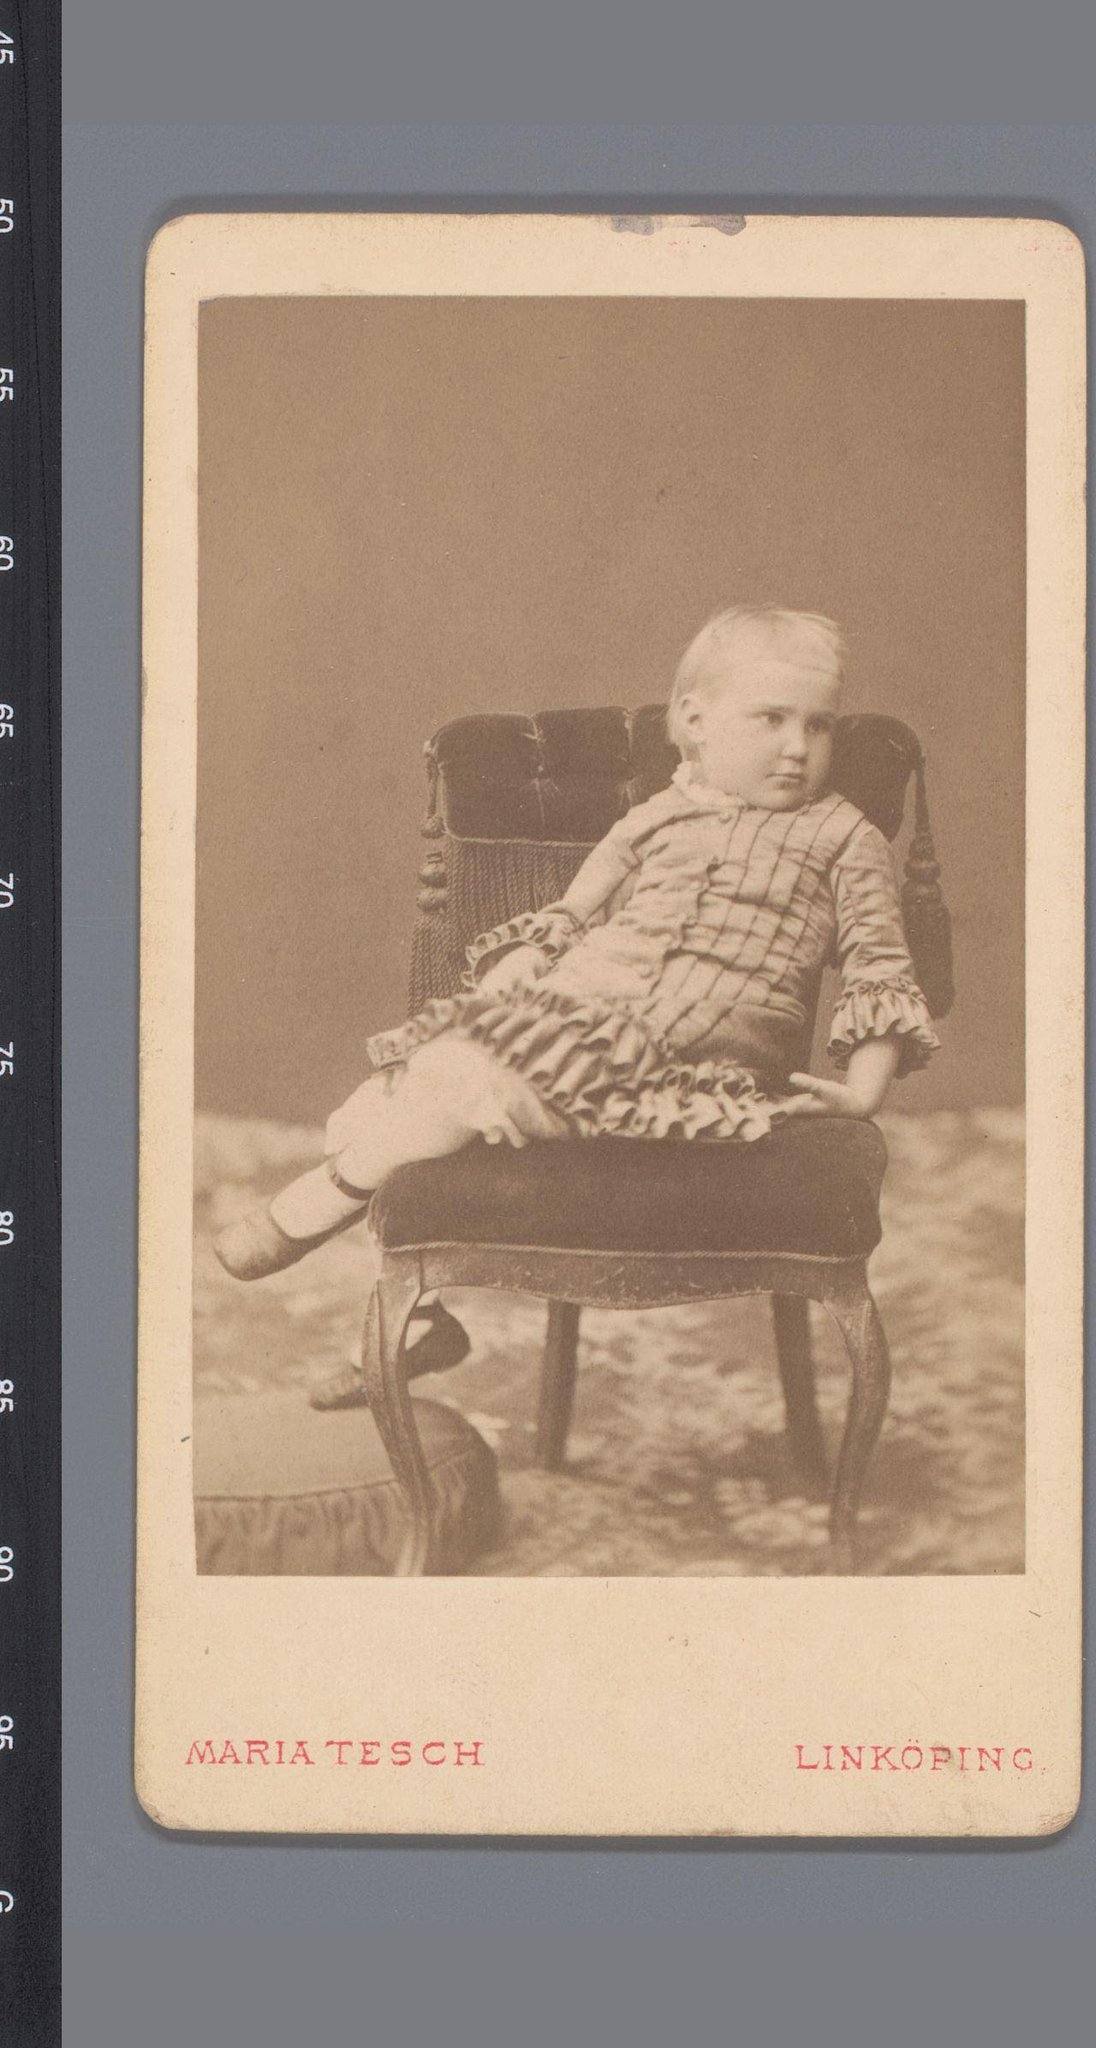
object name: carte de visite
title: Portret van een onbekend meisje, zittend op een stoel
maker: maria tesch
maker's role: fotograaf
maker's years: 1850-1936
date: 1873-1917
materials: cardboard, paper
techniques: albumen print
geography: linköping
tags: girl (child between toddler and youth), anonymous historical person portrayed, chair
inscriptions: inscription: ‘Maria Tesch/ LINKÖPING/ No. 20, Nygatan No. 20./ F. & N.’